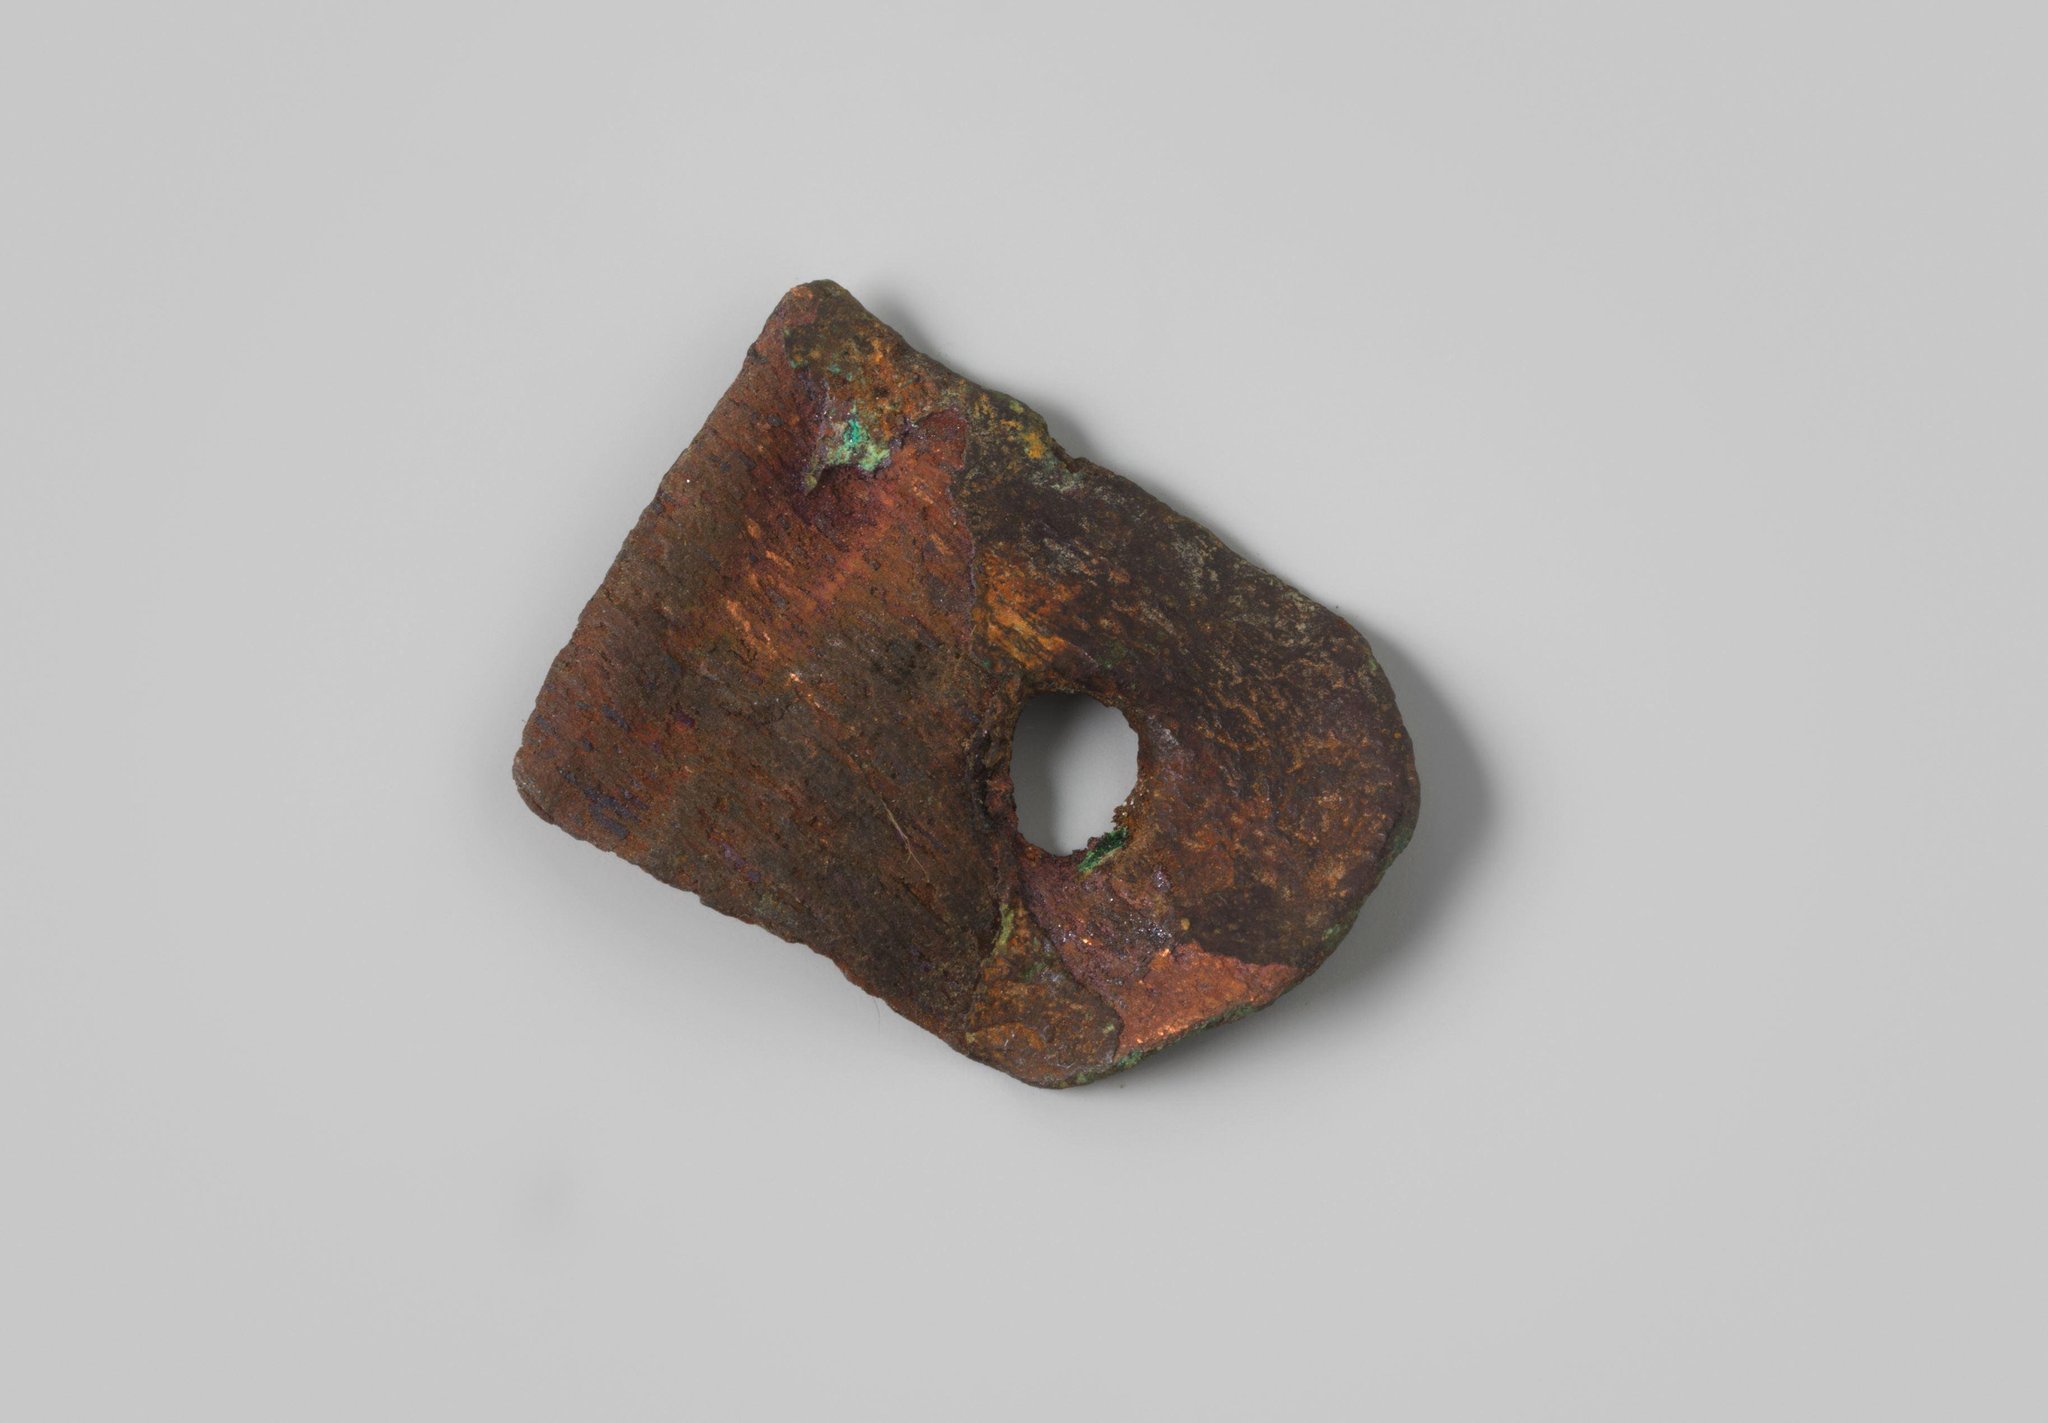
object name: cartridge canister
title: Oor van een kardoeskoker uit het wrak van de Oost-Indiëvaarder Hollandia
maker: Anonymous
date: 1700-1743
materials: copper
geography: netherlands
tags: verenigde oostindische compagnie, hollandia (schip), annet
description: Cartridge canister, lug; fragm of strip, cut-corner end with rivet-hole sim. NG 1980-27H2394.